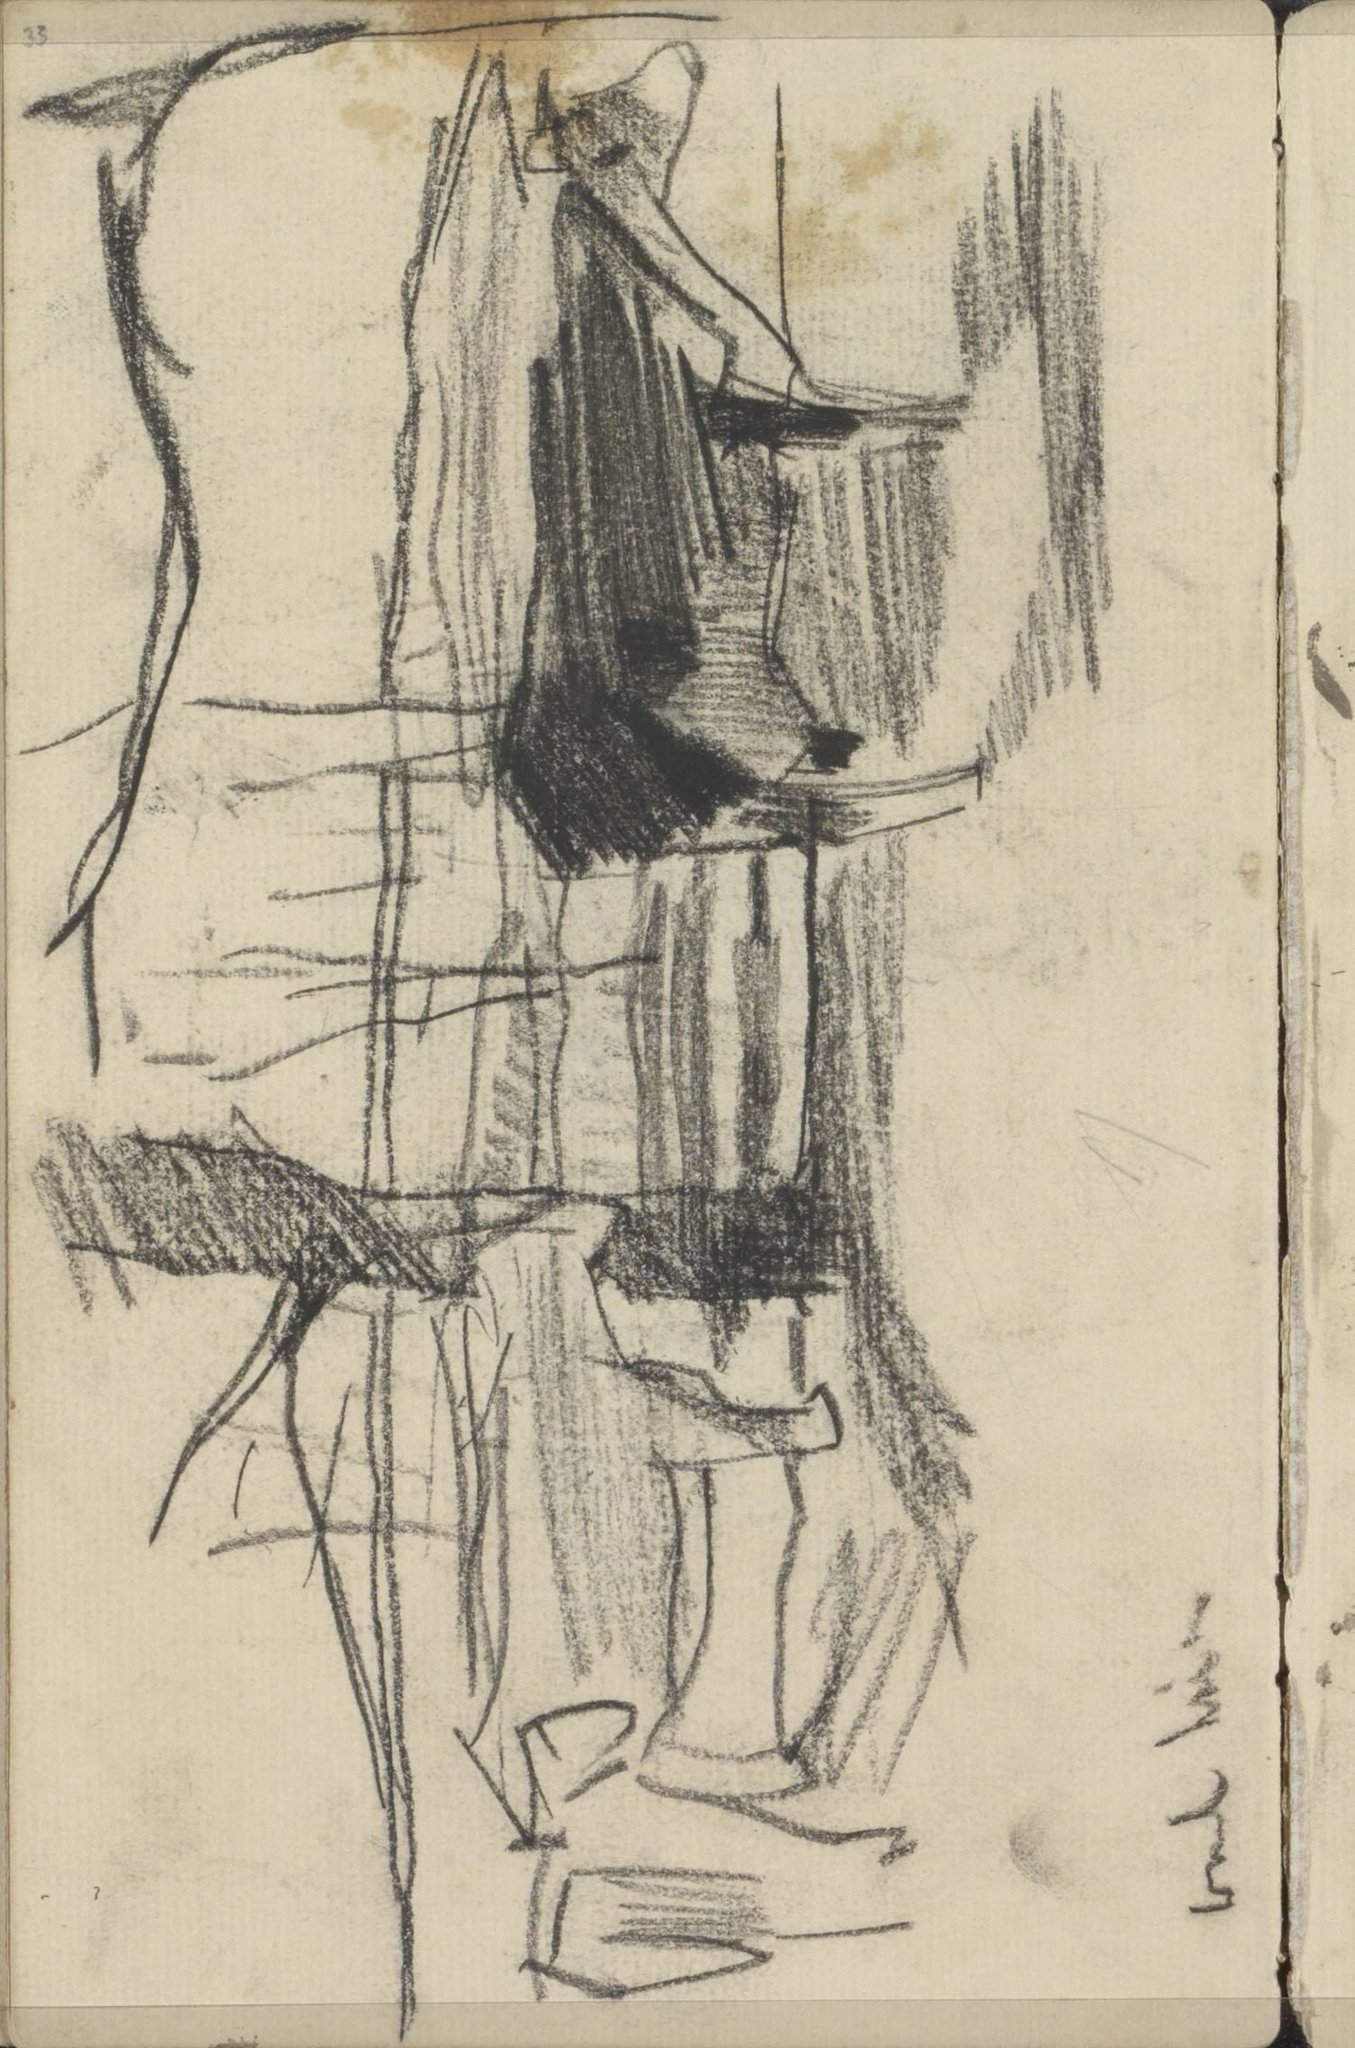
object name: sketchbook leaf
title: Landschap met koeien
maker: george hendrik breitner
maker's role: draughtsman, painter, print maker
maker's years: 1857-1923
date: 1883-1884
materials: chalk, paper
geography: the hague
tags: cow, landscapes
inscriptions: annotation: ‘[...]’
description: Pagina 33 uit een schetsboek met 23 bladen.